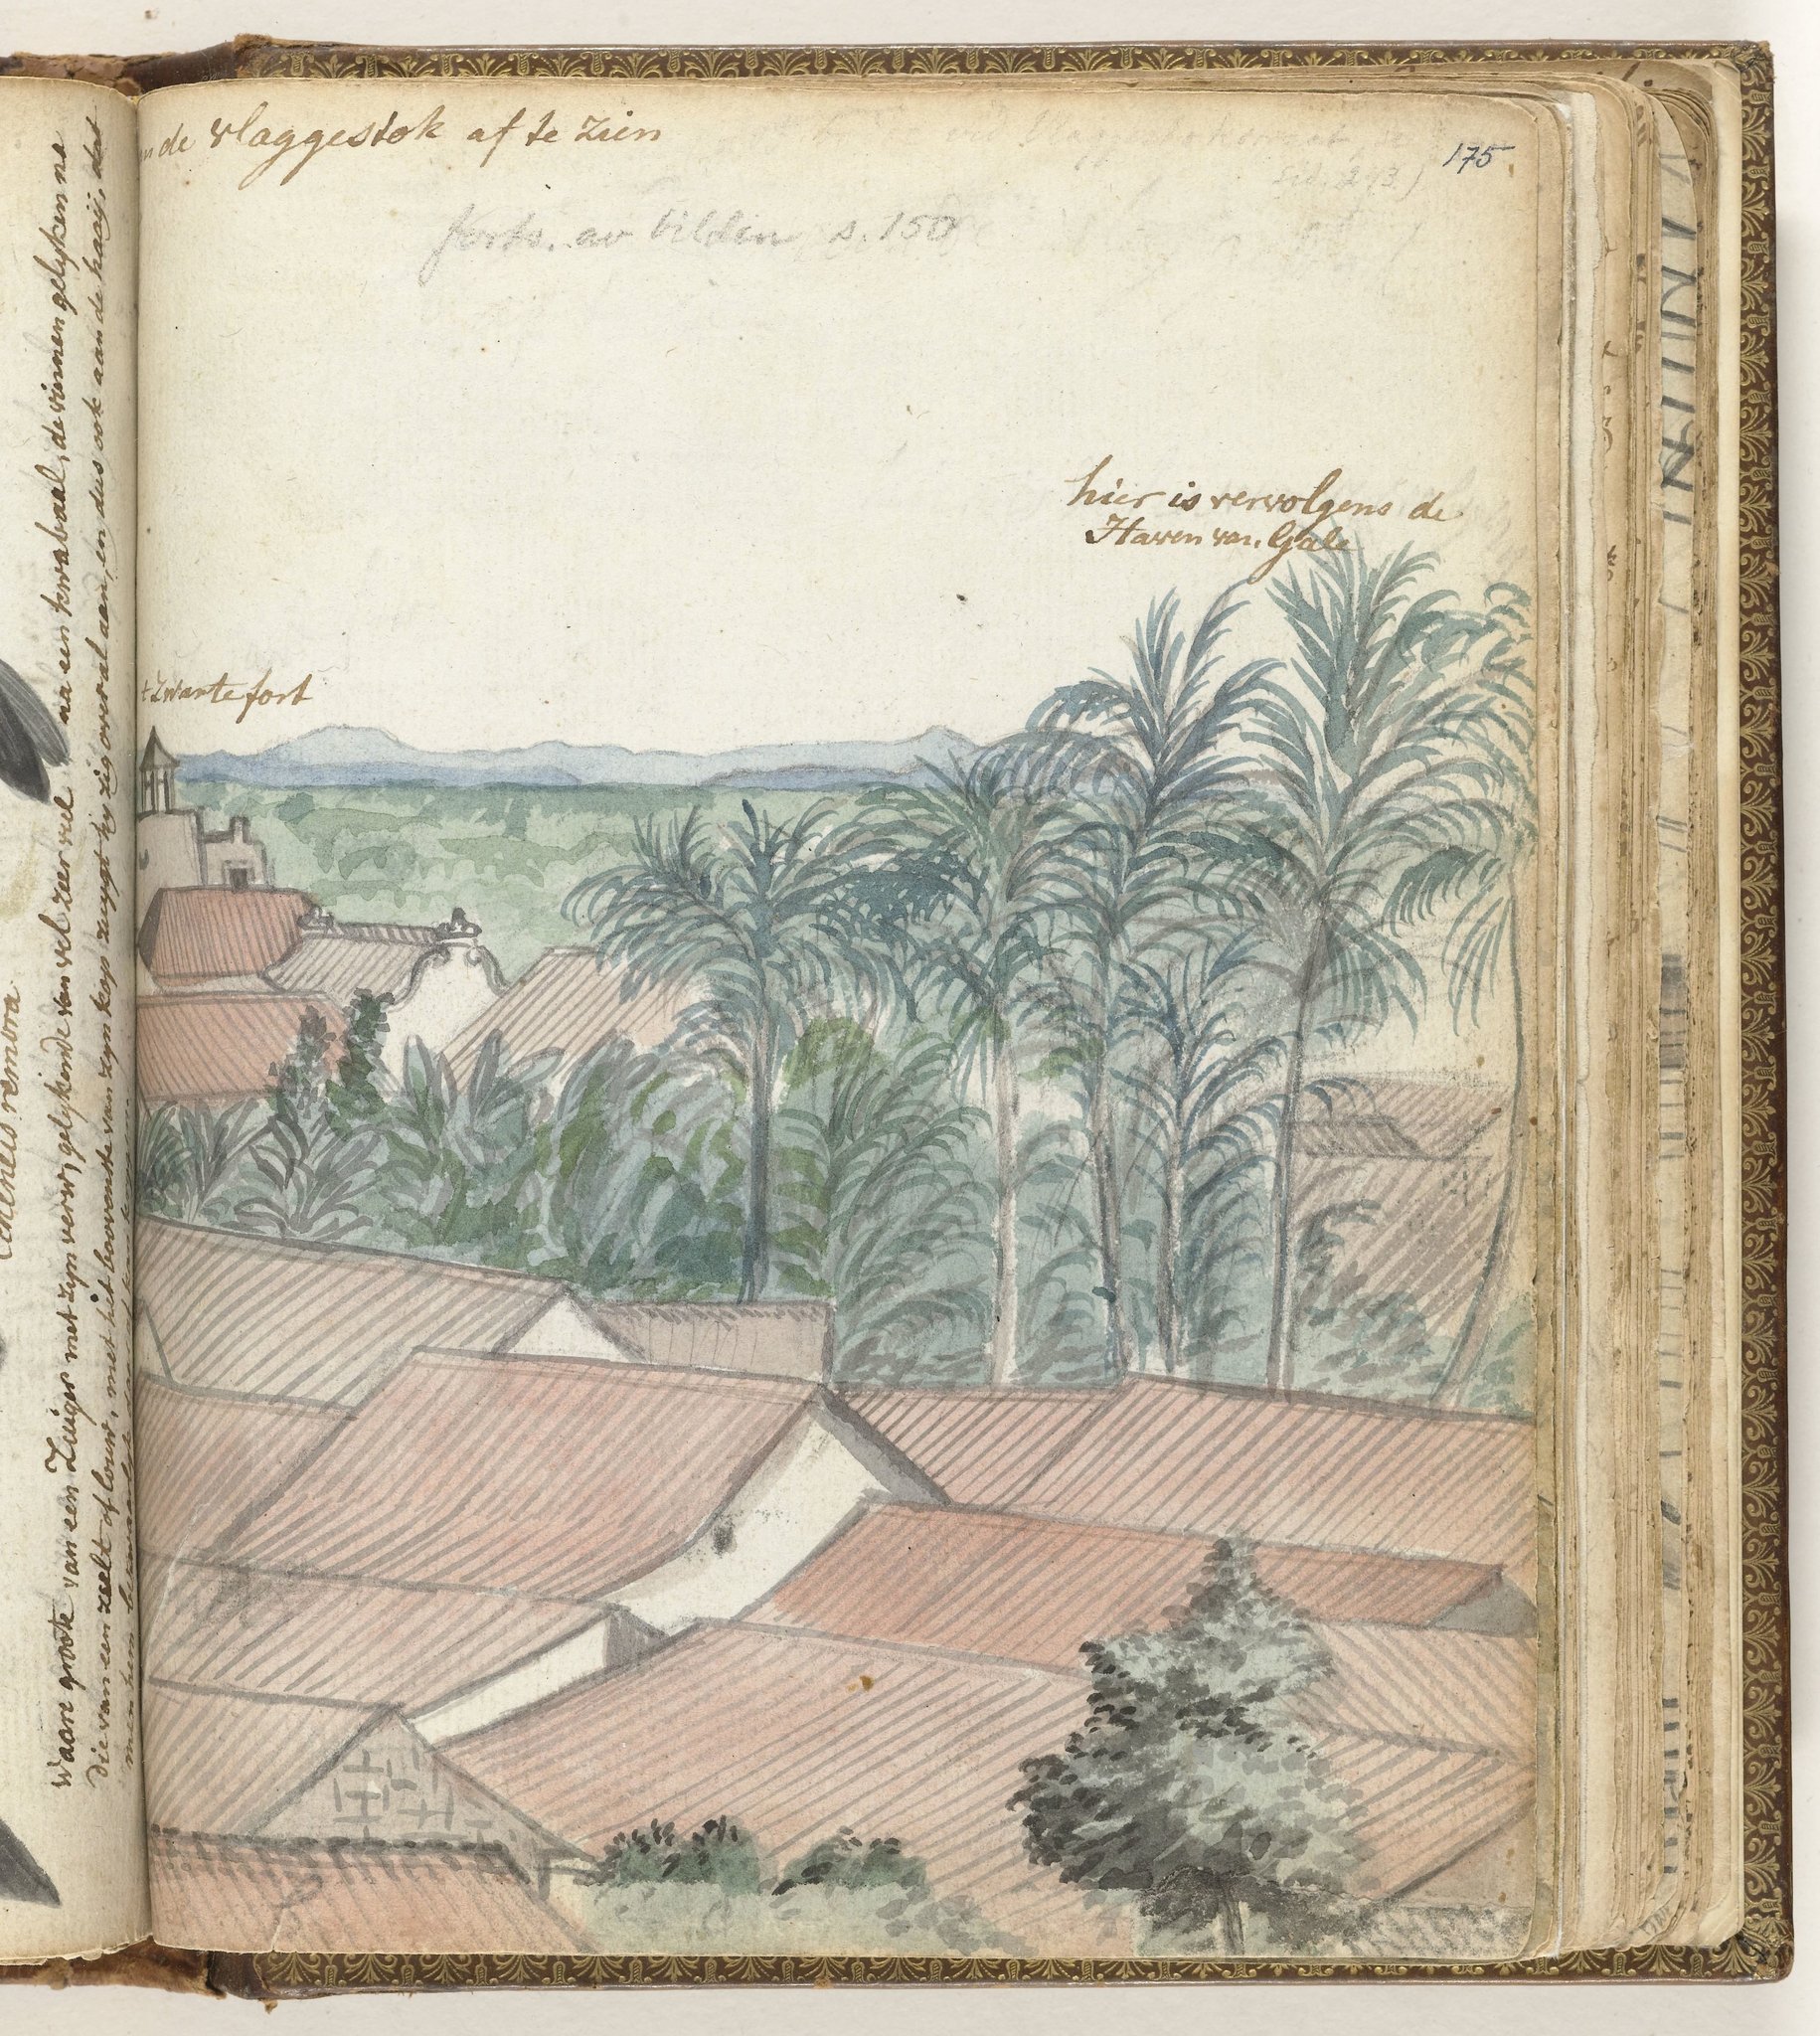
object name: drawing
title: View over Galle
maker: jan brandes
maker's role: draughtsman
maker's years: 1743-1808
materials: paper, pencil, watercolor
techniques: brush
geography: galle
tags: city-view in general; 'veduta'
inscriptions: inscription: ‘t Zwarte fort / hier is vervolgens de Haven van Gale’, inscription: ‘van de vlaggestok af te zien’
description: Kleurtekening van Galle met het Zwarte Fort. Met opschrift. Onderdeel uit het schetsboek van Jan Brandes, dl. 2 (1808), p. 175 en zie 148-150. (Deze tekening hoort rechts van deel 2, p.150.)